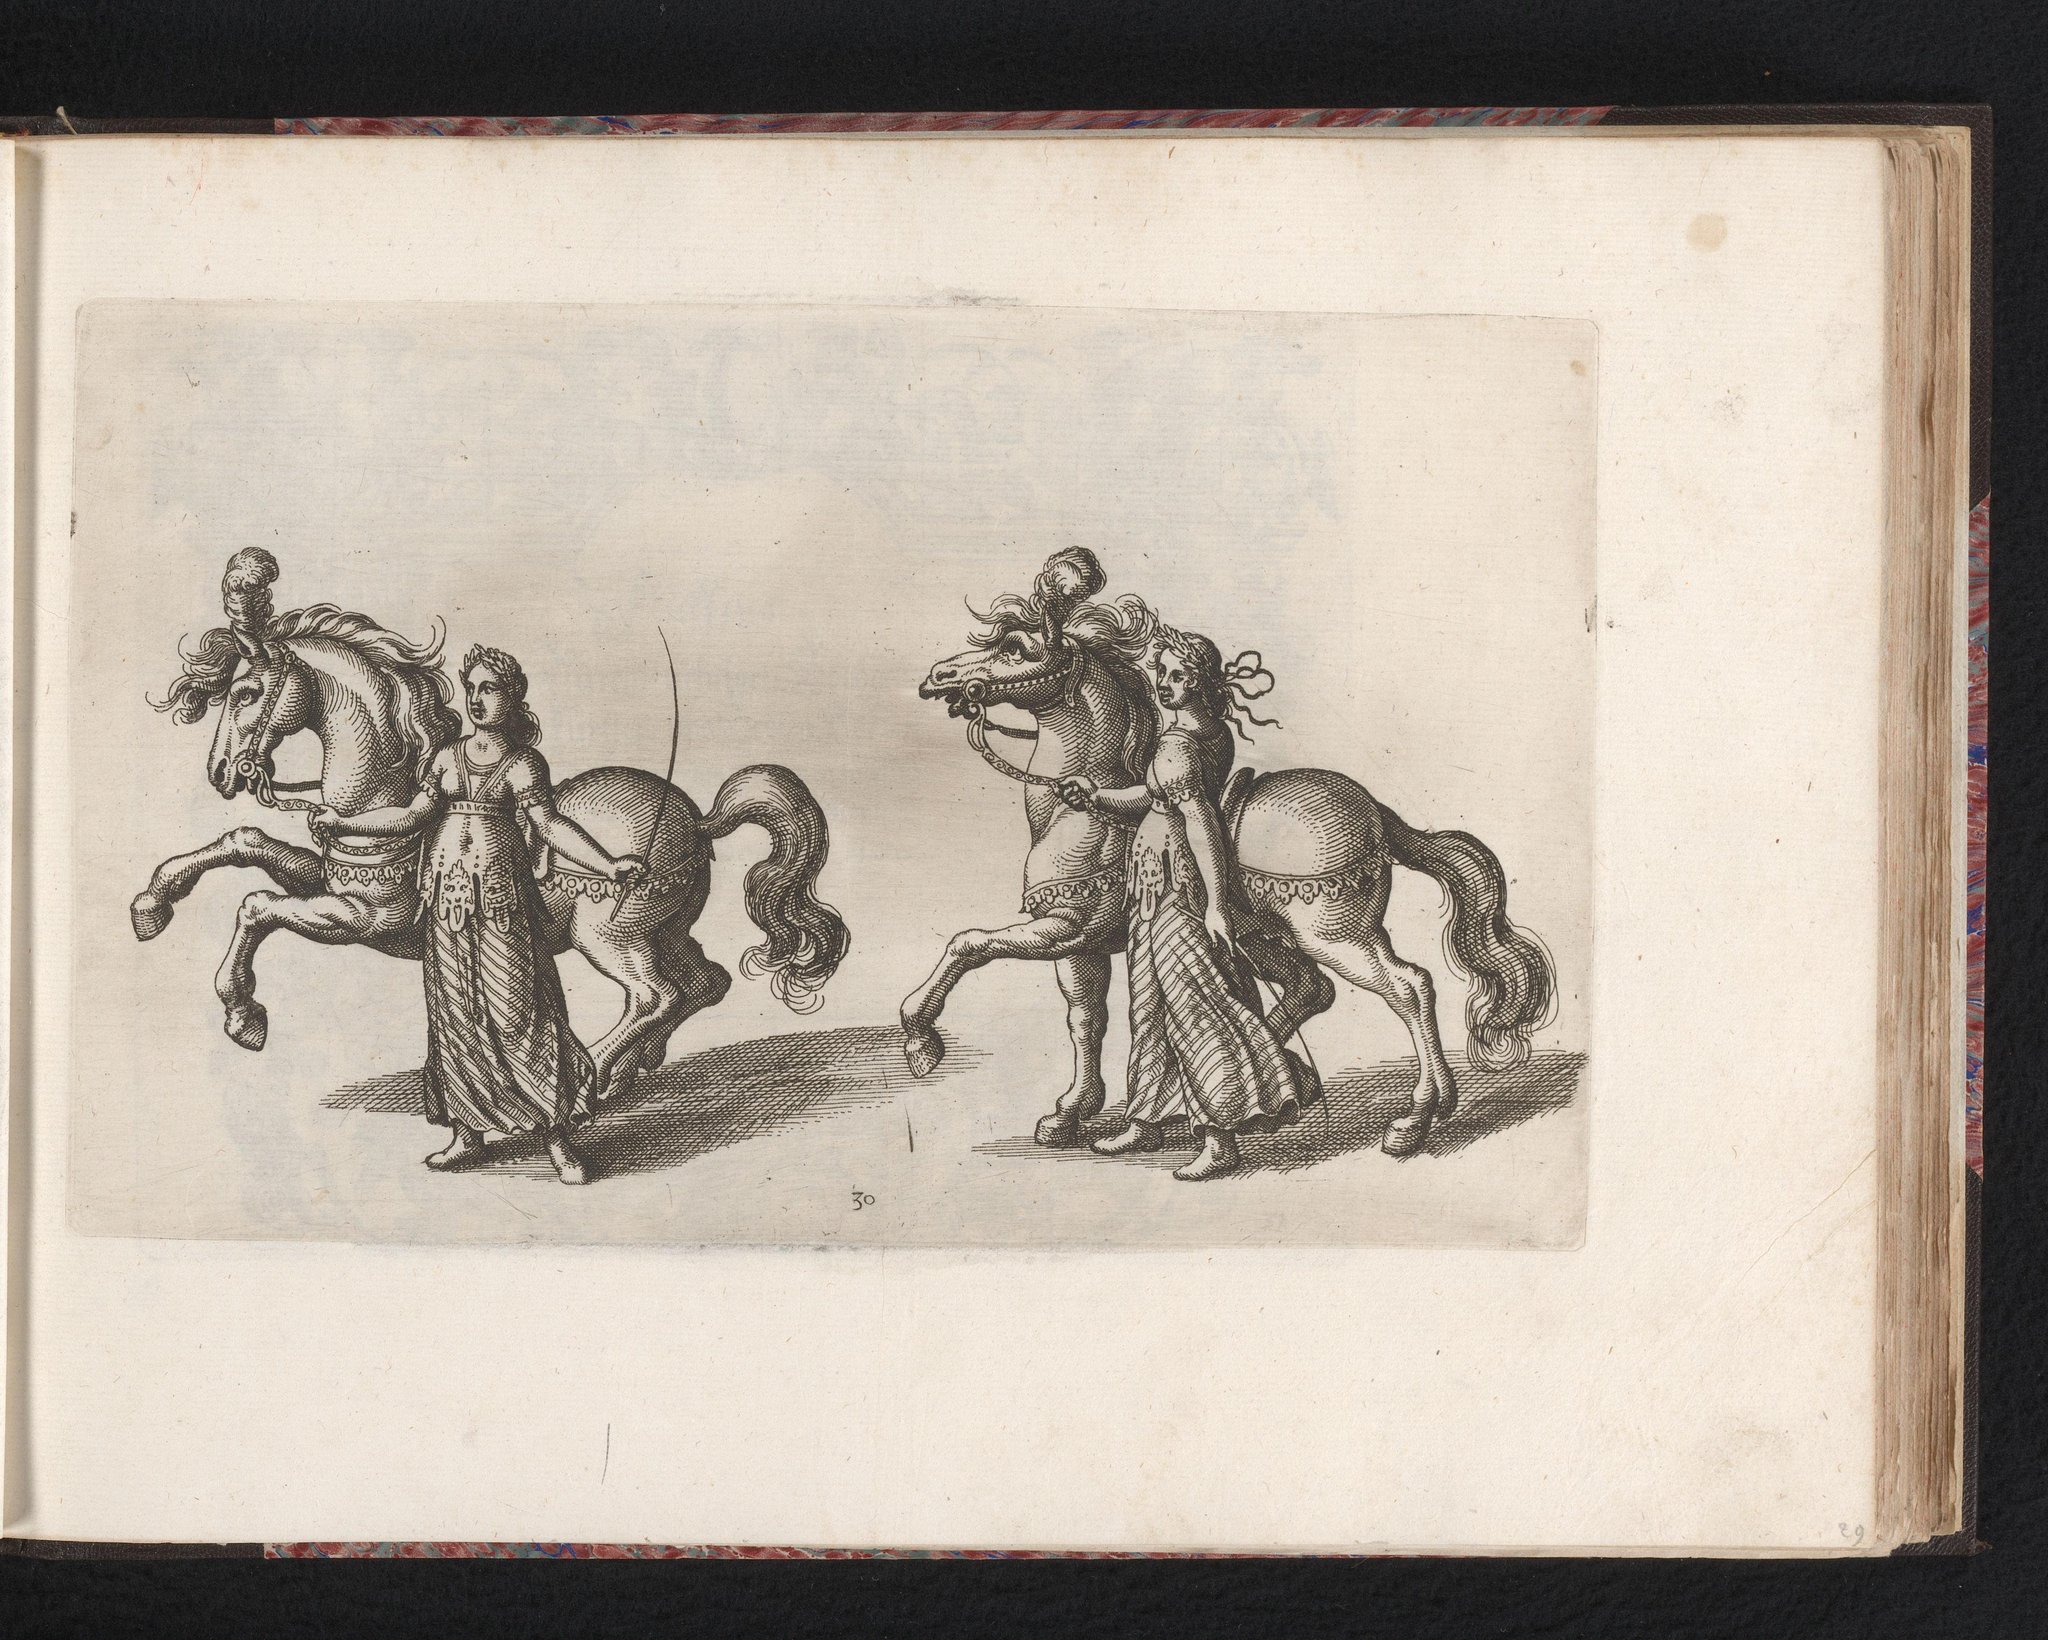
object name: print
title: Aigentliche wahrhaffte Delineation unnd Abbildung aller fürstlichen Auffzüg und Rütterspilen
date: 1618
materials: paper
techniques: etching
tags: performance in the open air (pleasure fair), horses (circus performance)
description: Genummerd: 29. Deze prent maakt deel uit van een album.